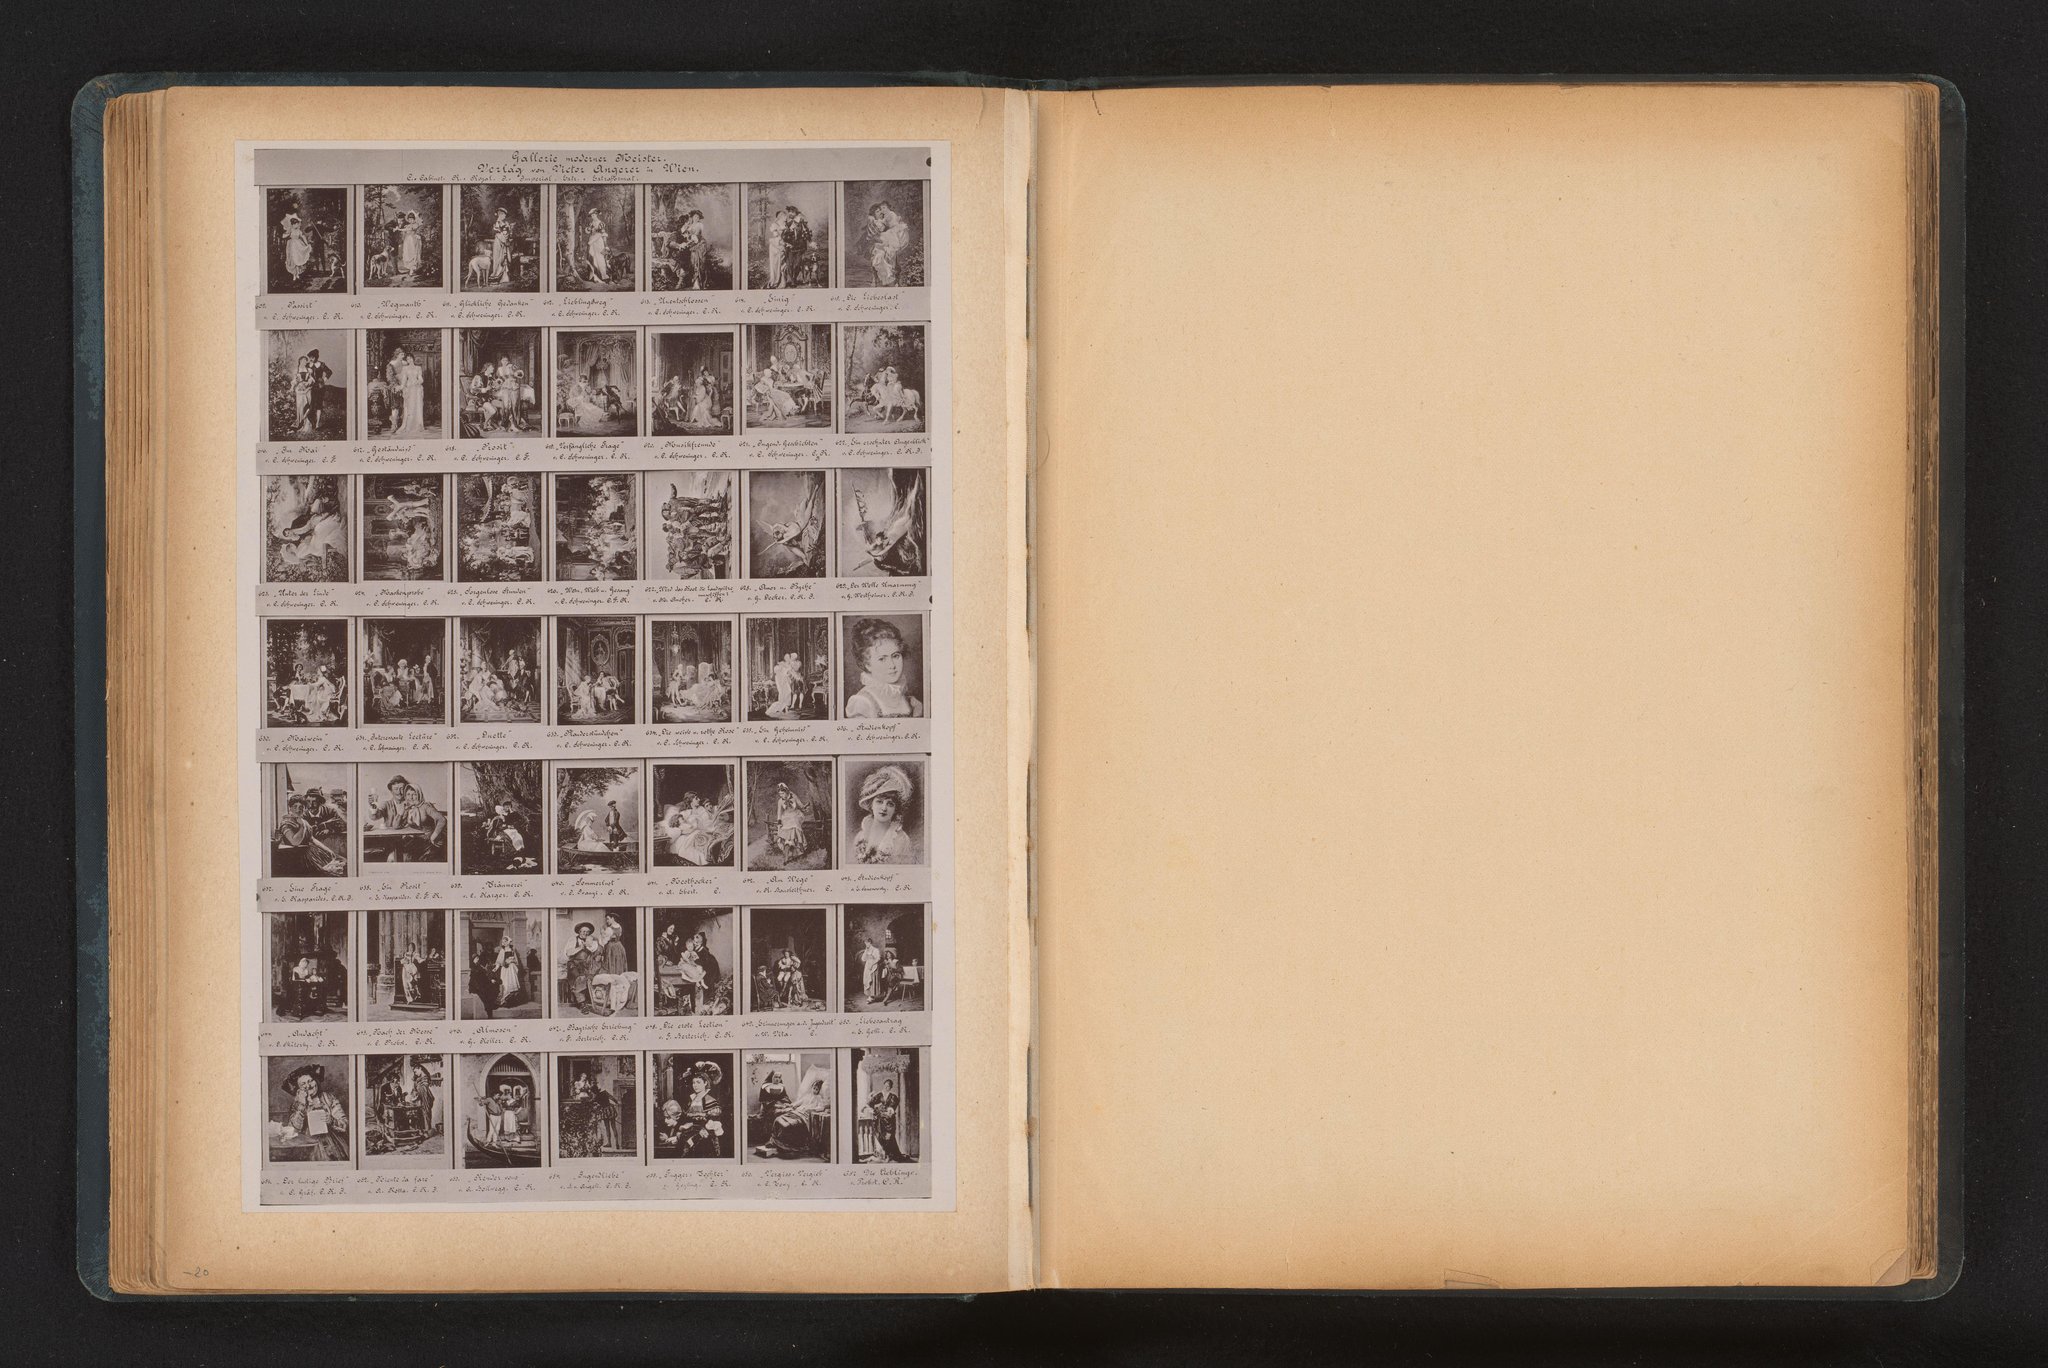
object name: page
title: Gallerie moderner Meister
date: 1880-1885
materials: paper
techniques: photograph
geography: berlin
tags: adult woman, adult man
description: Prent op twintigste ongenummerde pagina.